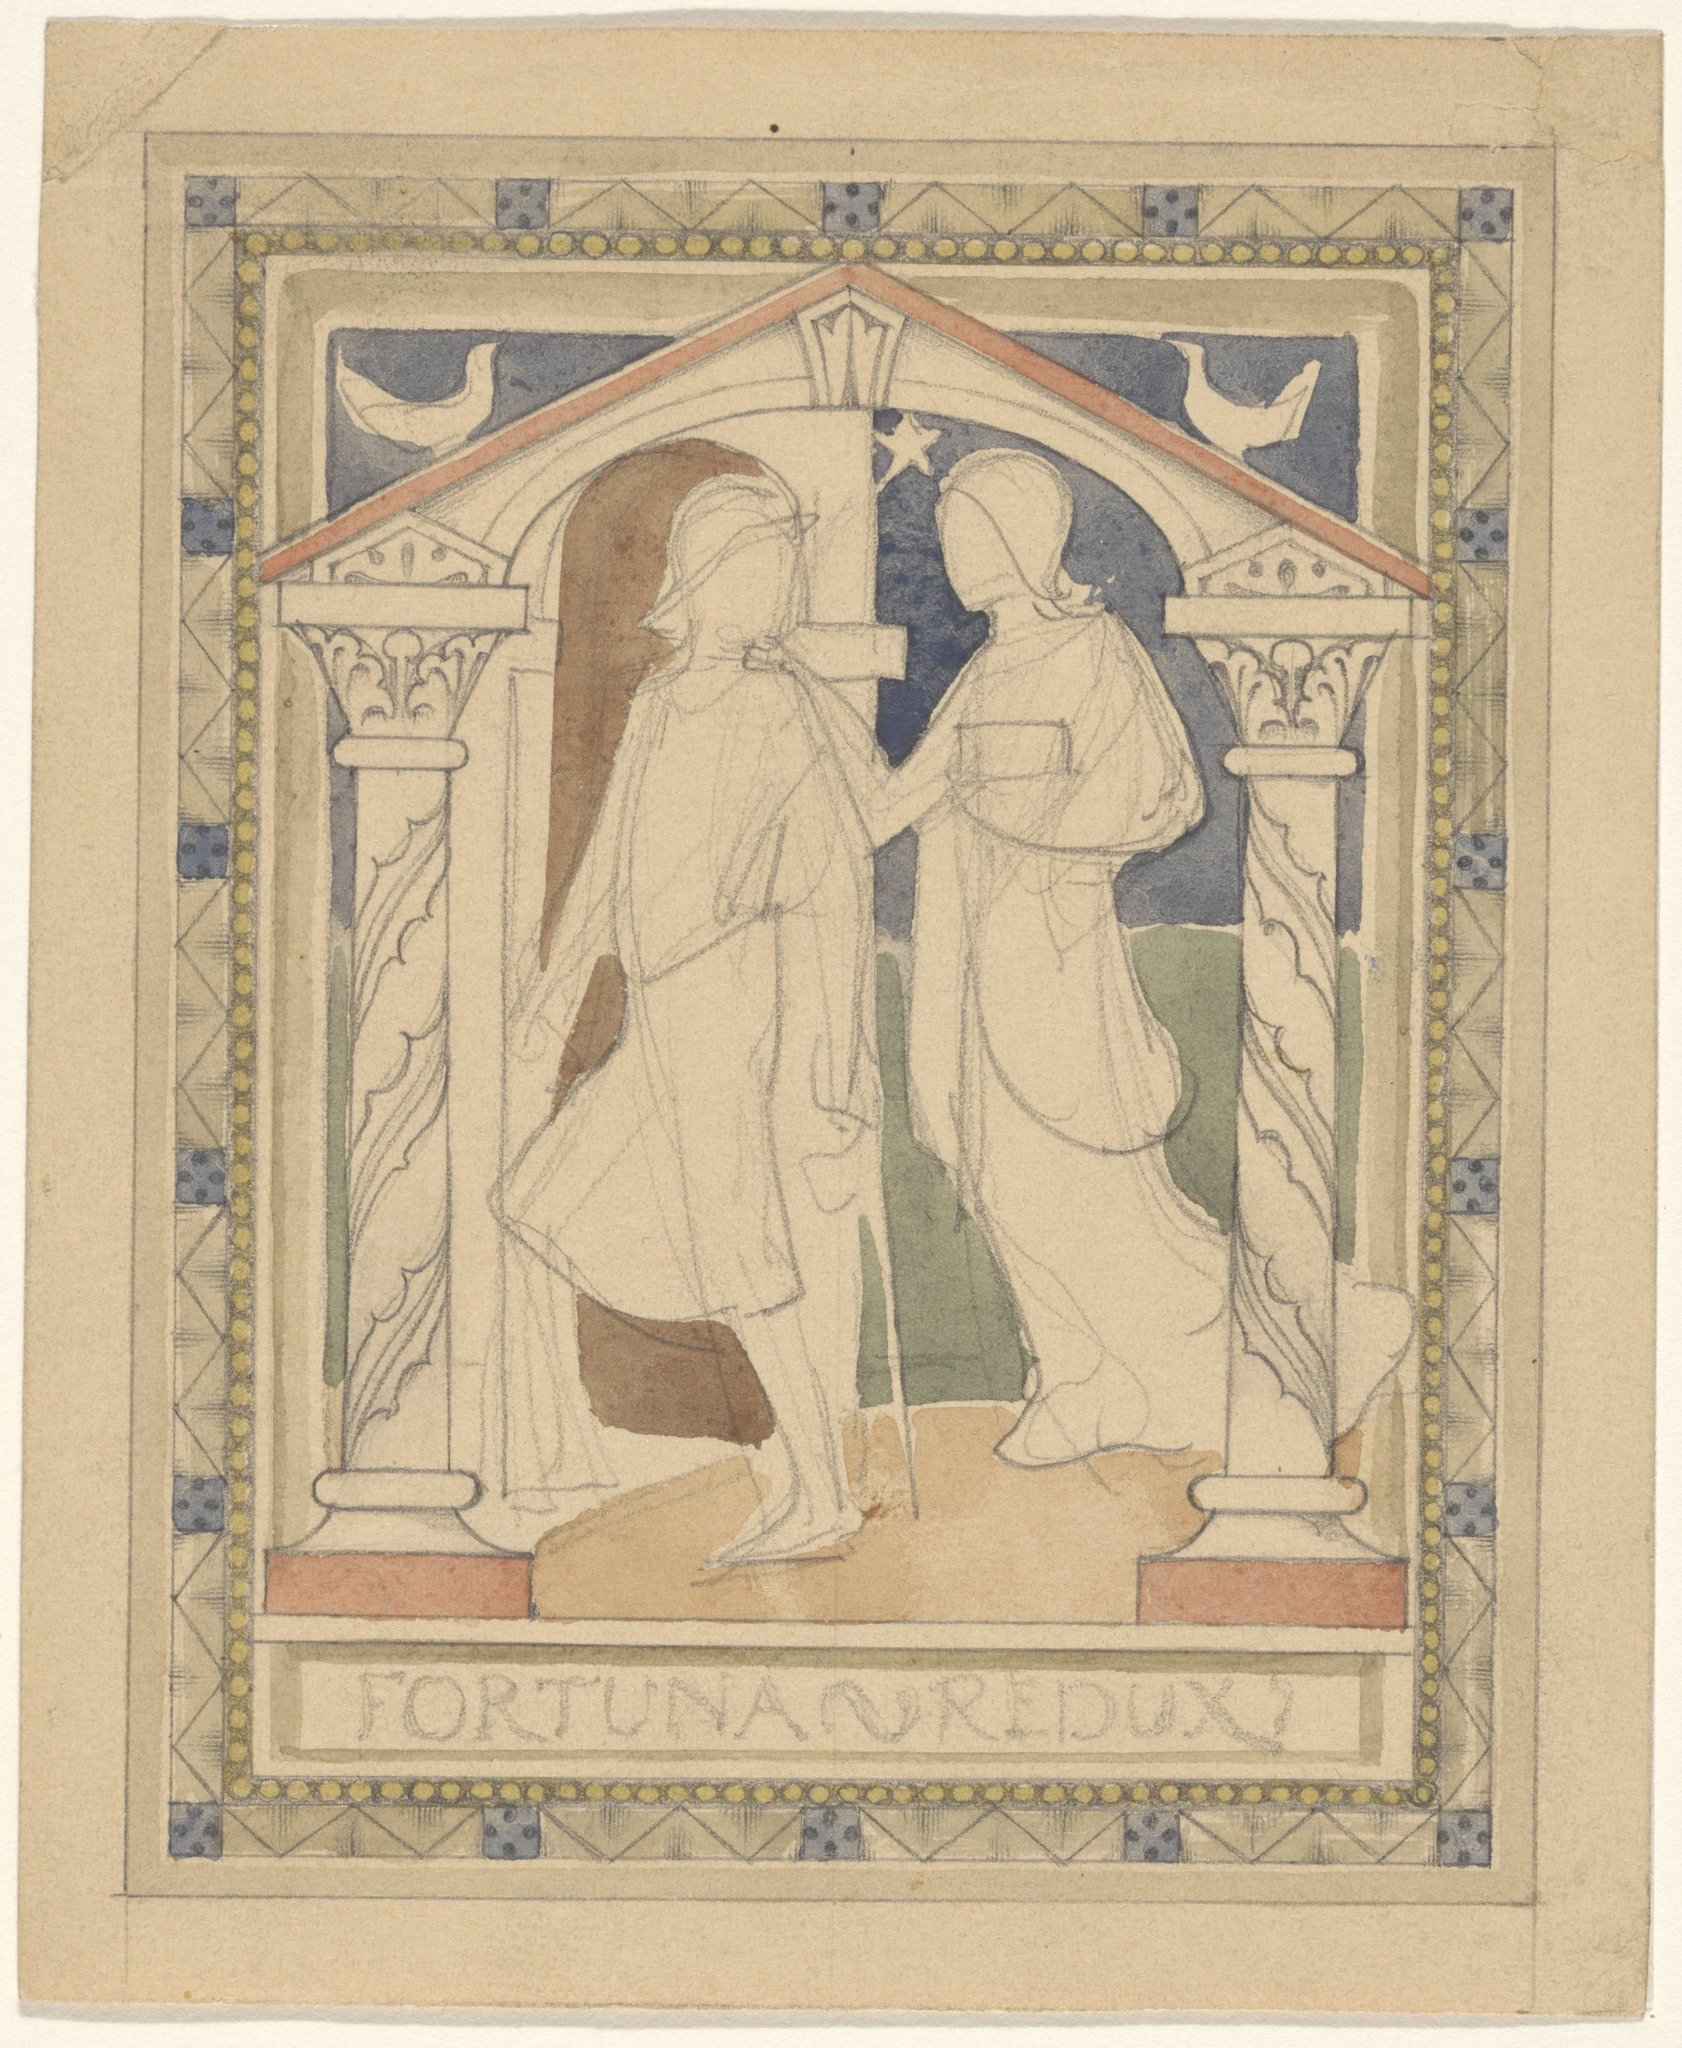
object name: watercolor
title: Fortuna Redux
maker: antoon derkinderen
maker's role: draughtsman, painter, print maker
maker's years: 1859-1925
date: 1869-1925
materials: paper, pencil, watercolor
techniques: brush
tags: arrival and return ~ travelling, luck, fortune, lot; 'fato', 'fortuna', 'fortuna aurea', 'fortuna buona', 'fortuna pacifica overo clemente', 'sorte' (ripa)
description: Ontwerp voor glasschildering in het huis van S. de Swart en Em. van Kerckhoff te Laren: Fortuna Redux.